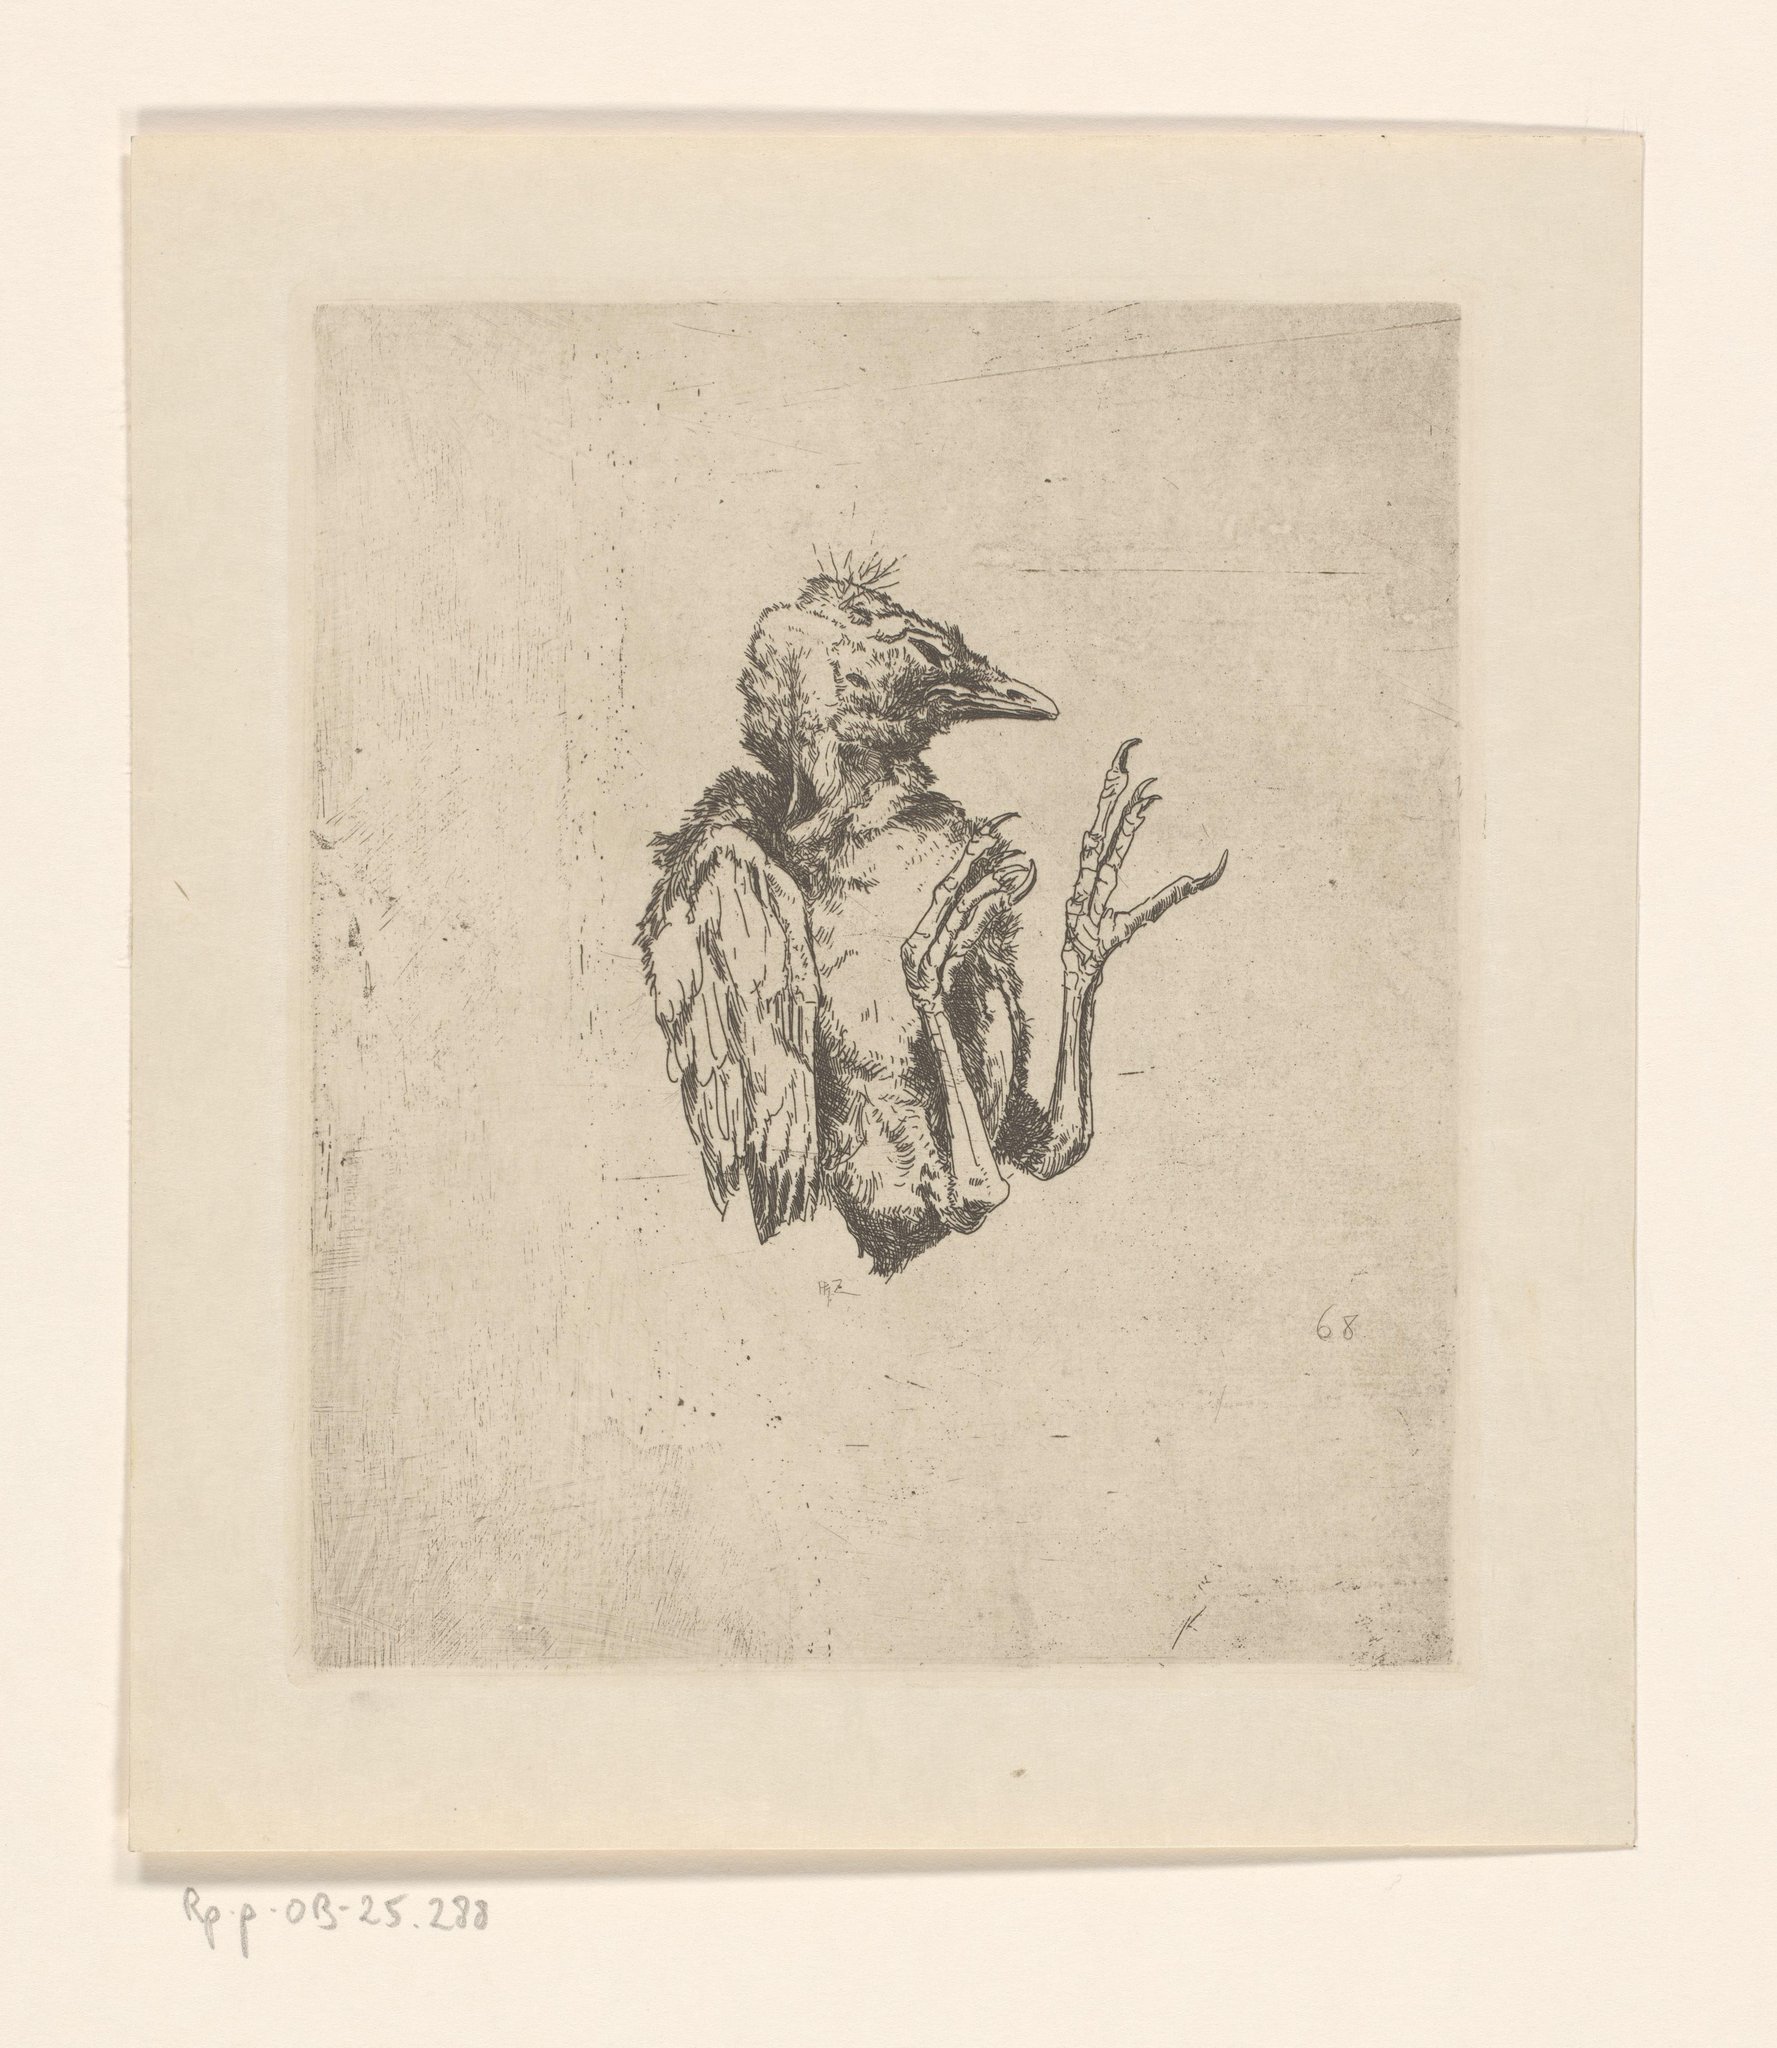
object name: print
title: Jonge dode vogel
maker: philip zilcken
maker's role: draughtsman, painter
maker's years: 1857-1930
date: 1867-1888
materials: paper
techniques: etching, intaglio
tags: birds (+ young animal)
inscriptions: collector's mark: Lugt 2228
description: Prent verscheen in 1888 als onderdeel van de jaarlijkse uitgave van de 'Portefeuille der Nederlandsche Etsclub'.